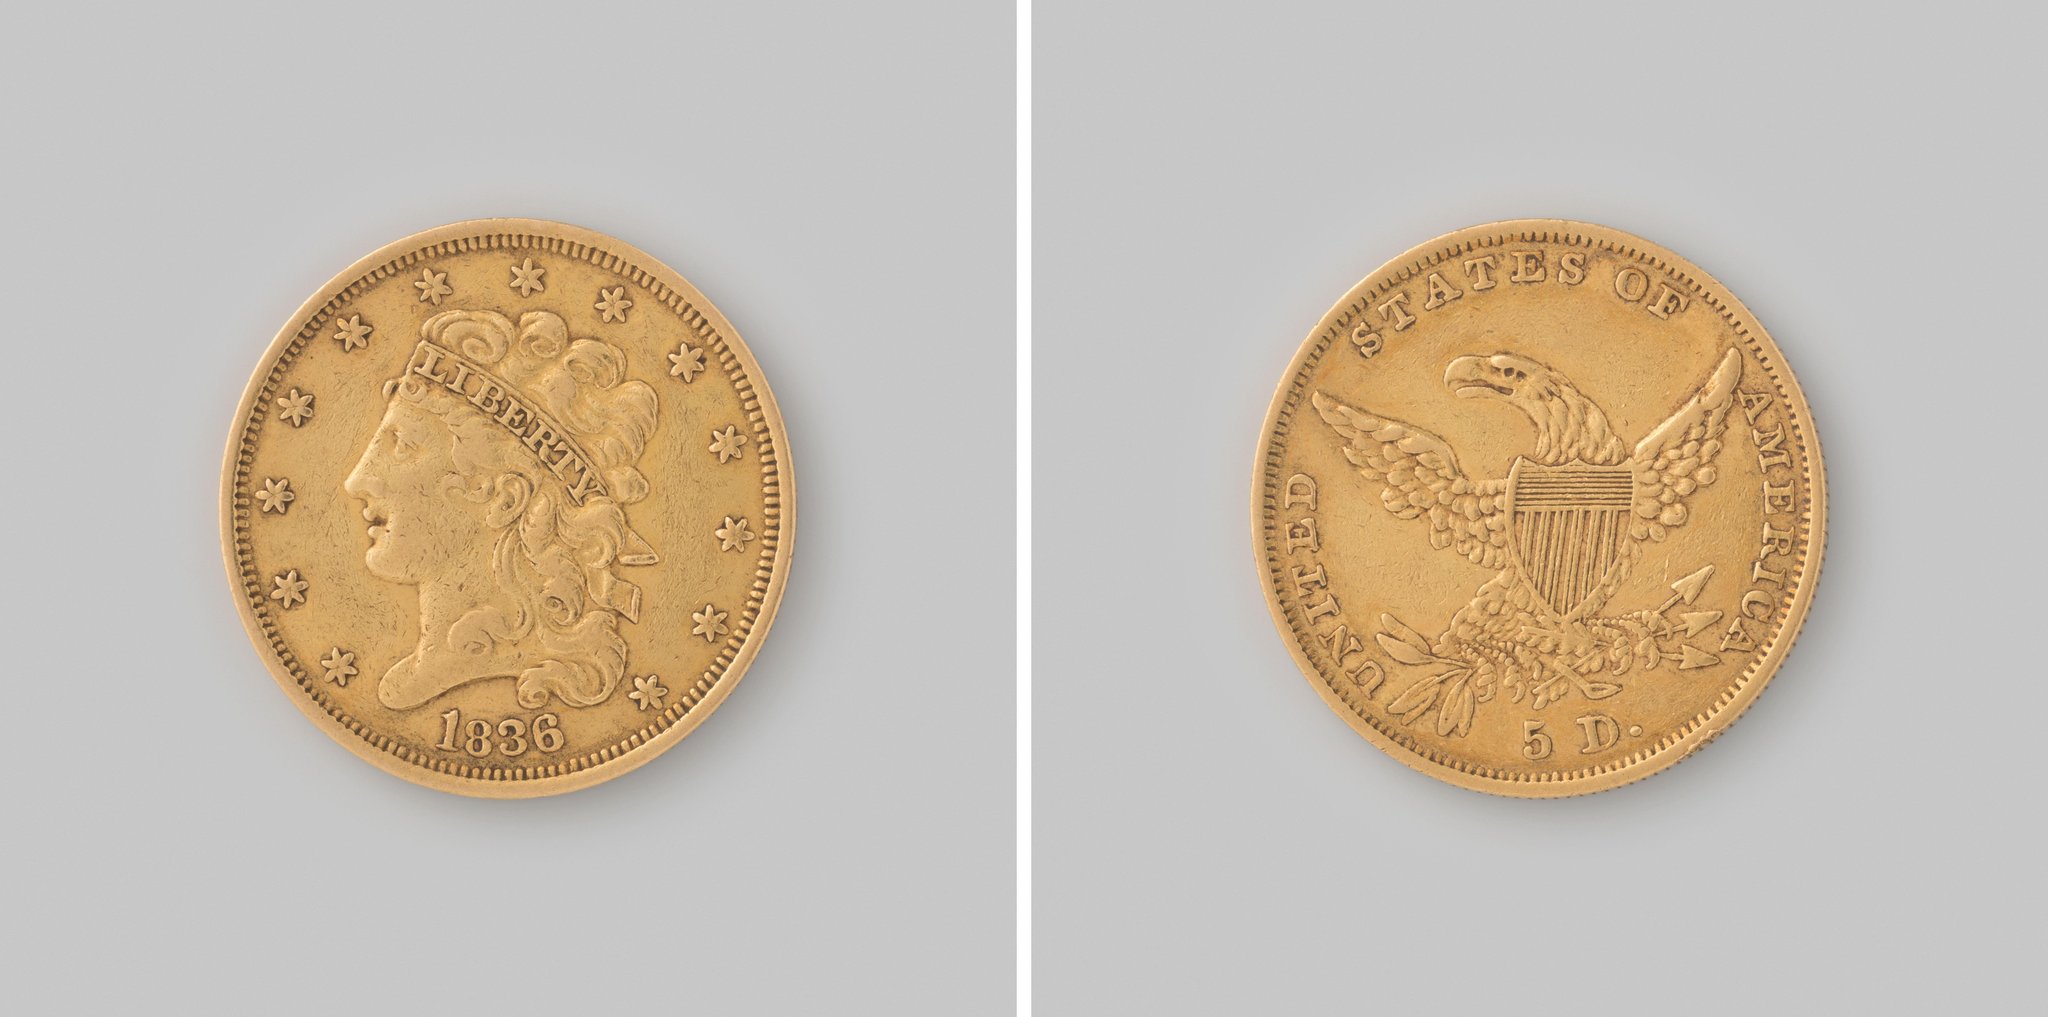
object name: half eagle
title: Vijf dollar of halve eagle uit de Verenigde Staten van Amerika, 1836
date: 1836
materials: gold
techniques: striking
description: Gouden munt. Voorzijde: hoofd (classic head) naar links, waaromheen sterren. Jaartal onderaan. Keerzijde: adelaar met gespreide vleugels met in zijn rechter klauw tak en in zijn linker klauw pijlenbundel en op zijn borst wapenschild, omkijkend naar links. Waarde-aanduiding onderaan. Kartelrand.